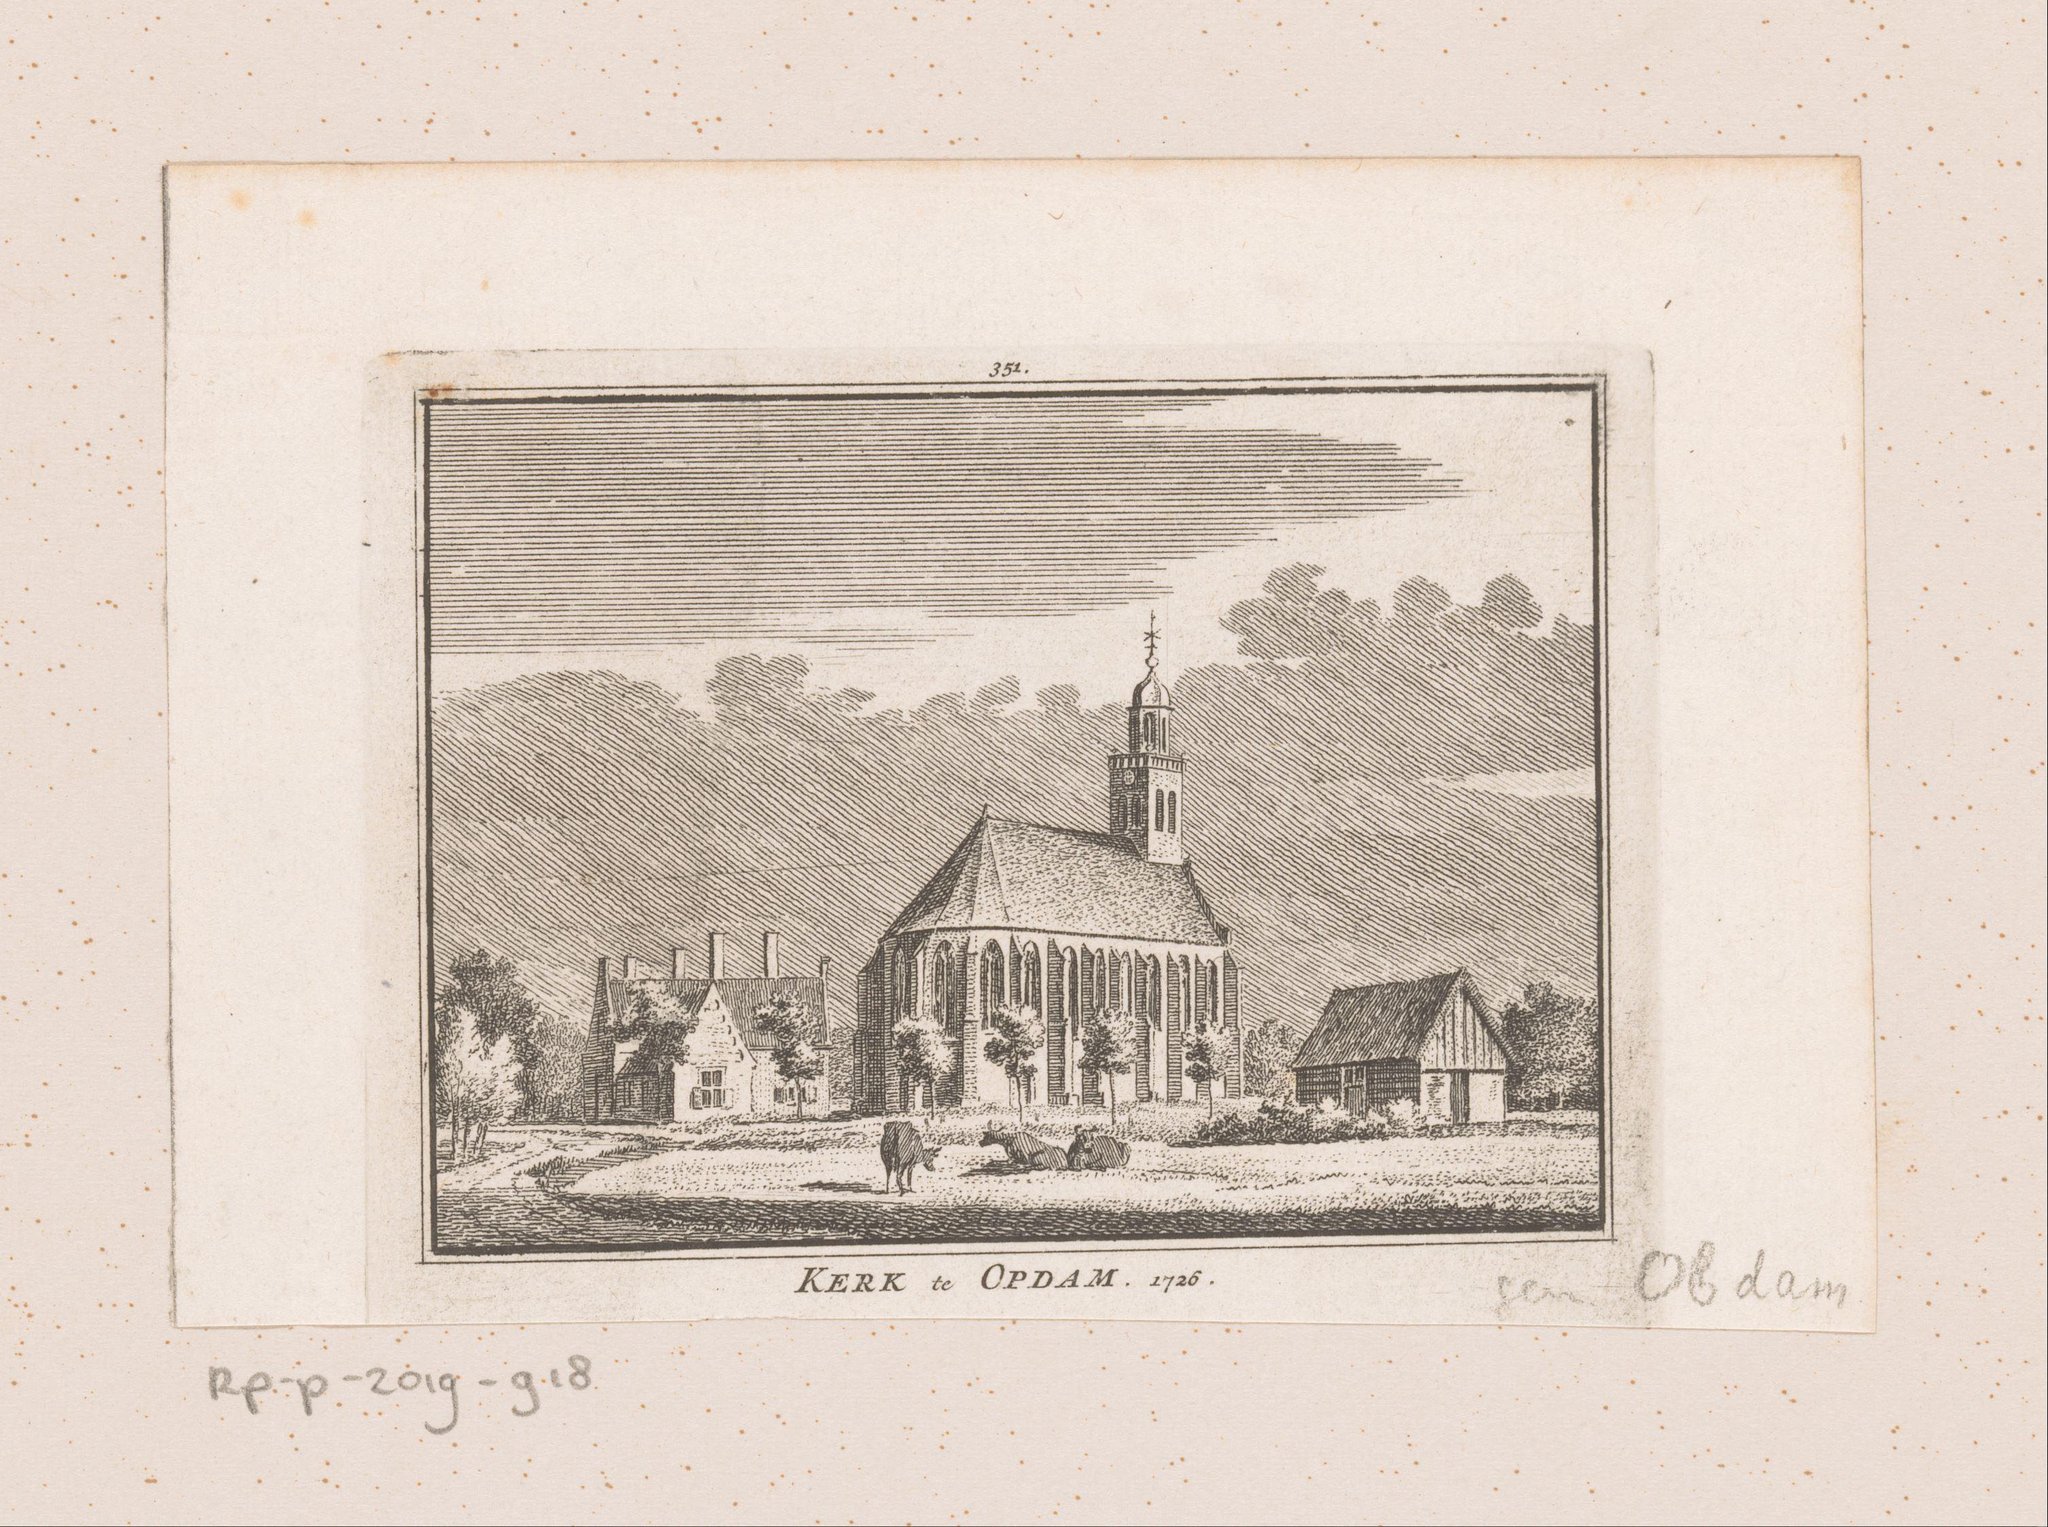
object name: print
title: Kerk te Opdam, 1726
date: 1745-1774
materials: paper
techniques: etching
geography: amsterdam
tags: the christian churches, city-view, and landscape with man-made constructions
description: Prent verschenen in: Het verheerlykt Nederland of kabinet van hedendaagsche gezigten. Amsterdam: Isaac Tirion, 1745-1774.